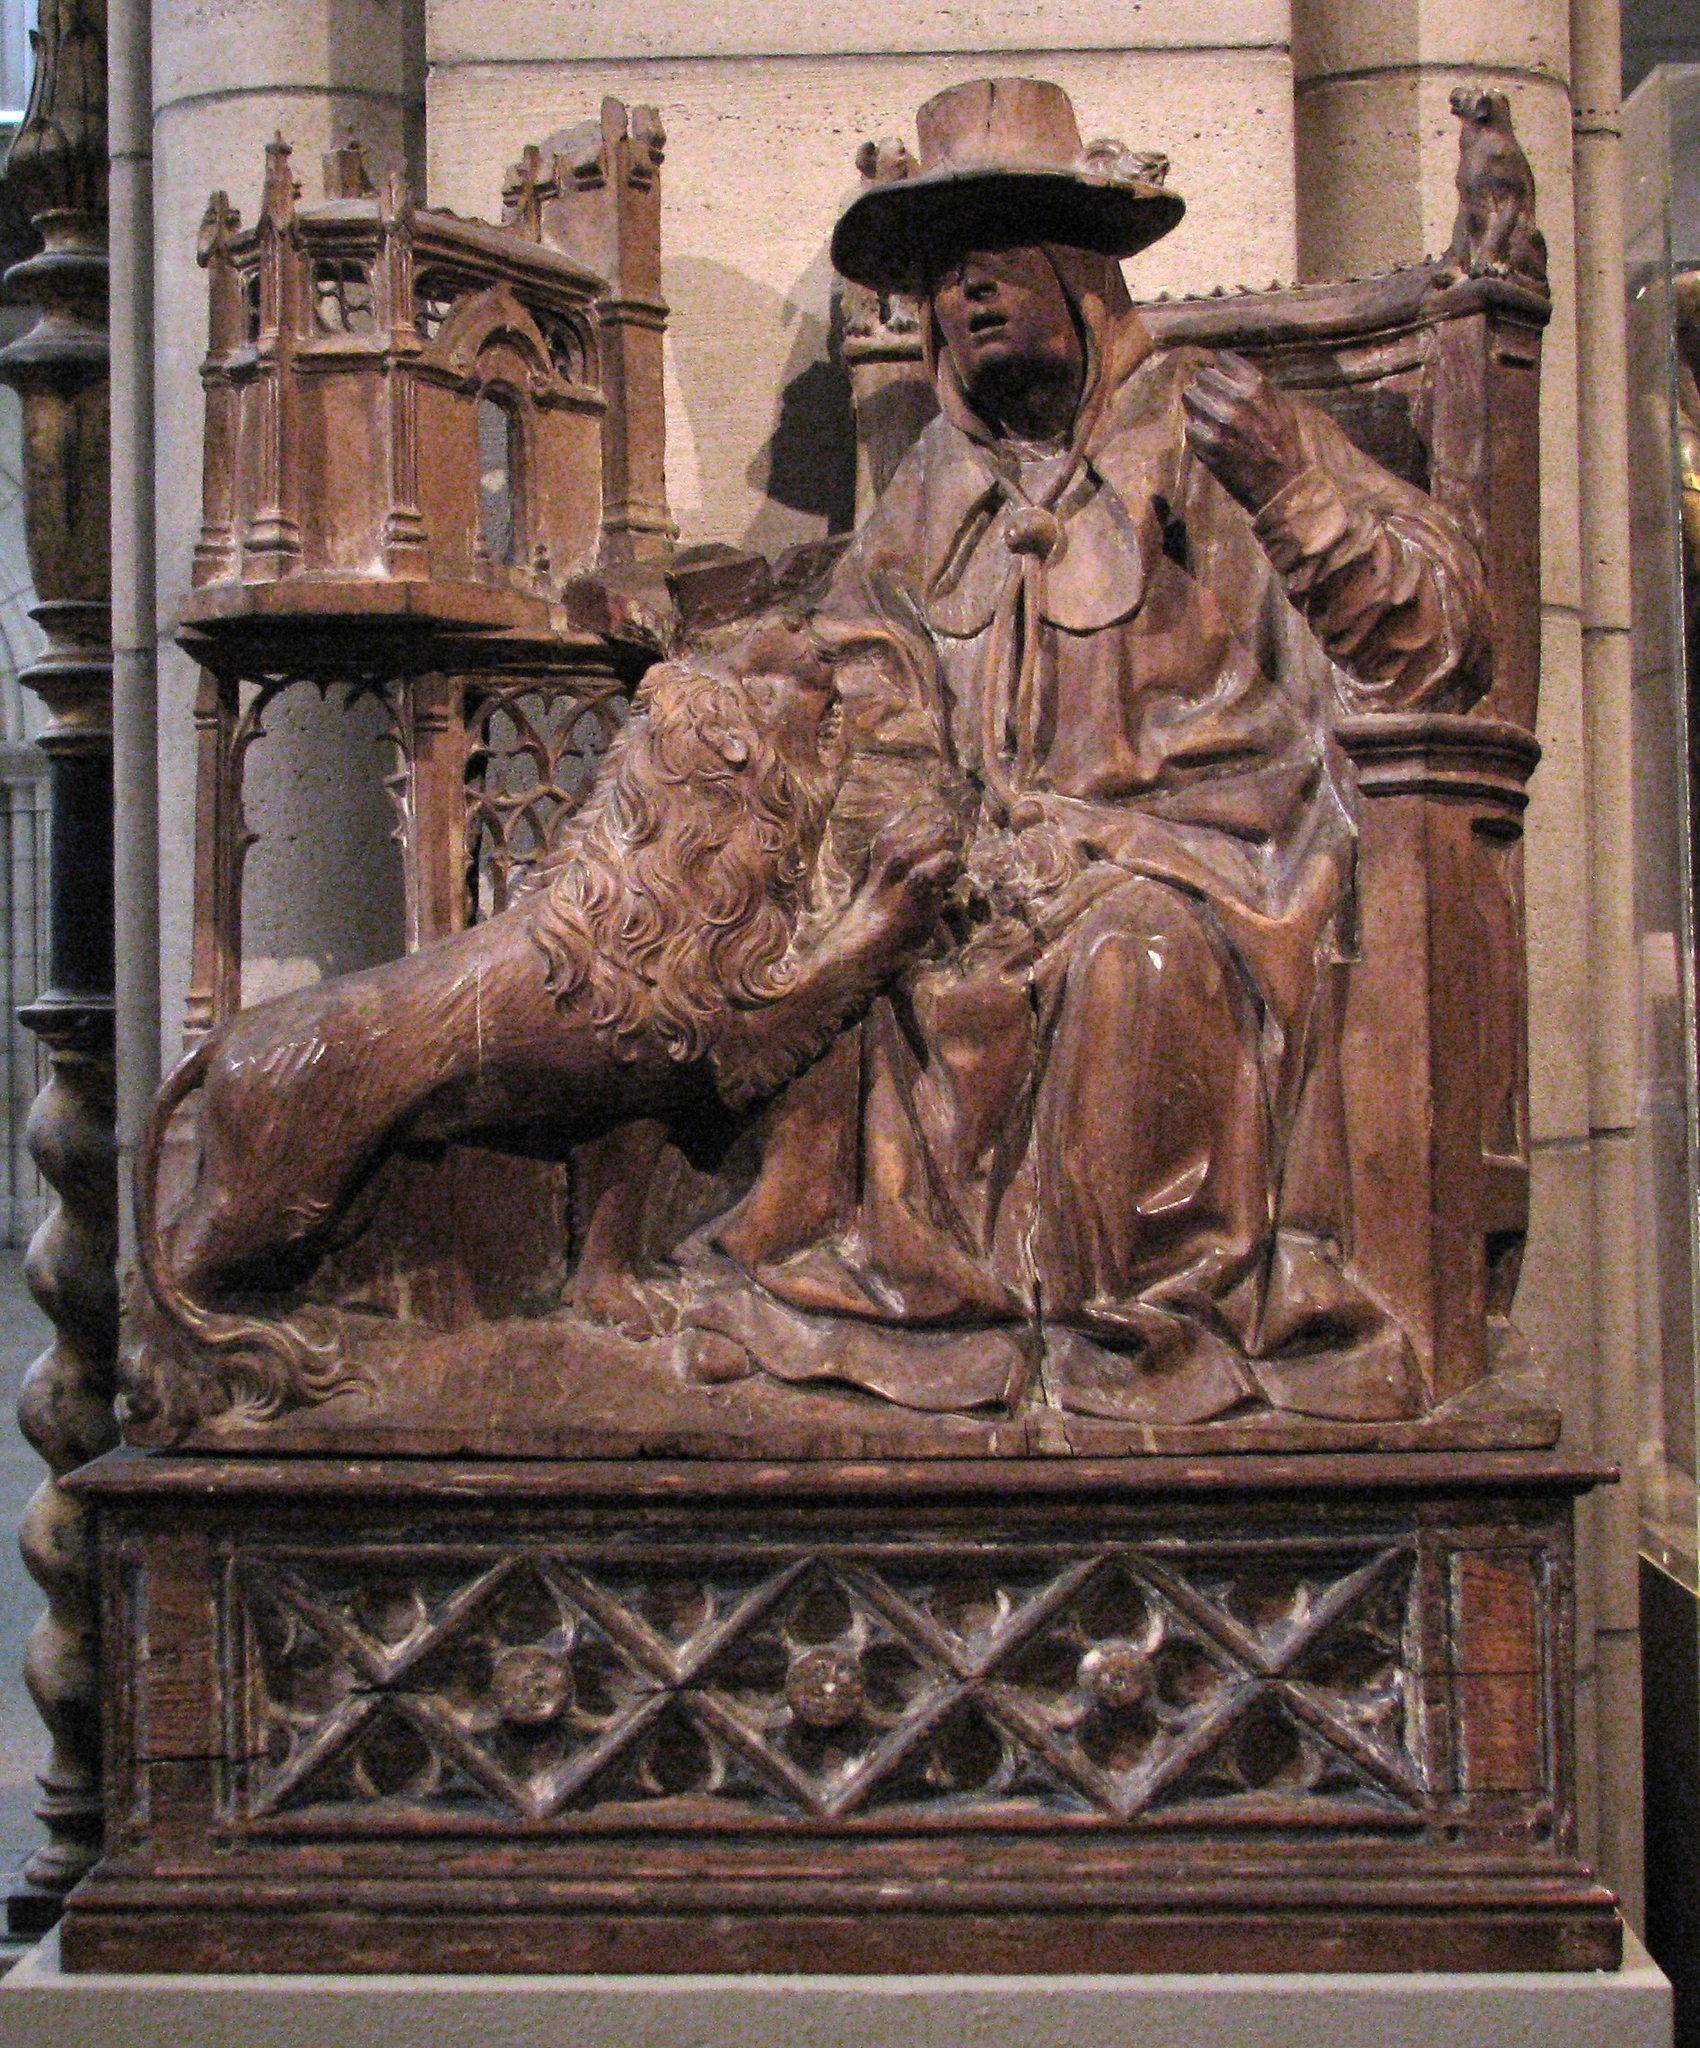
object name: relief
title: Saint Jerome at His Study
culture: spanish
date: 1500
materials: paint, wood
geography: spain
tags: lions